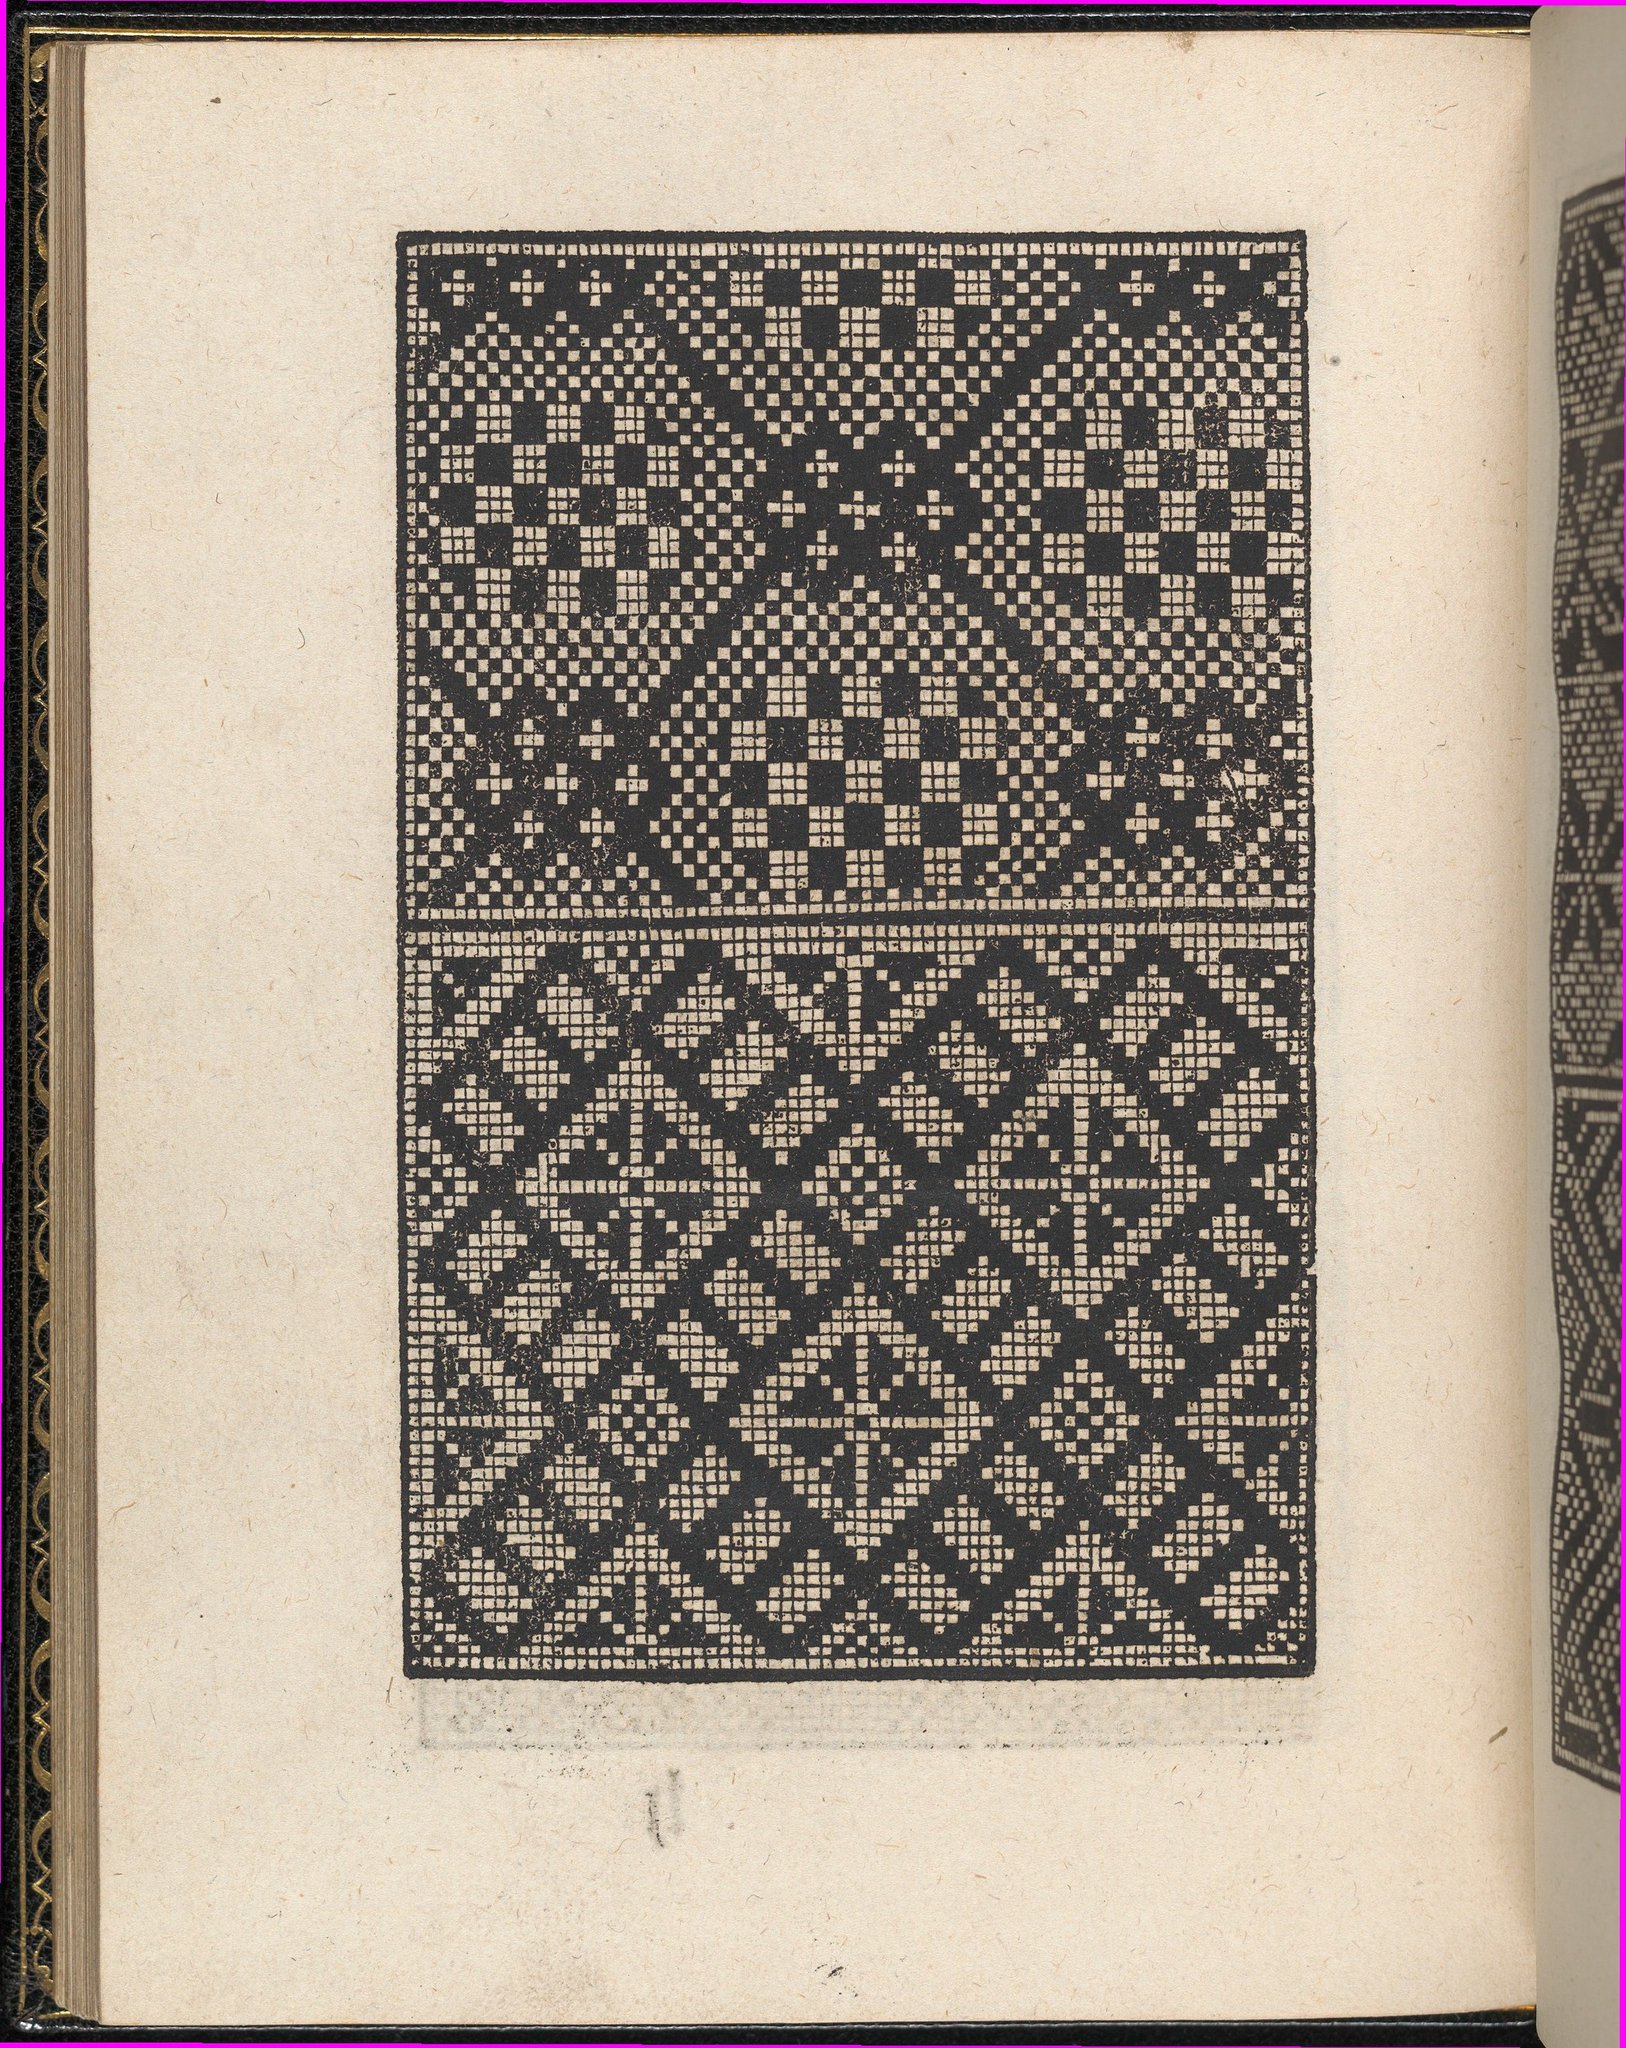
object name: book print ornament architecture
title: Page from Ein new kunstlich Modelbuch...(Page 36v)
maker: peter quentel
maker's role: publisher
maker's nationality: german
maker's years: 1500-1550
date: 1544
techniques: woodcut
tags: ornament